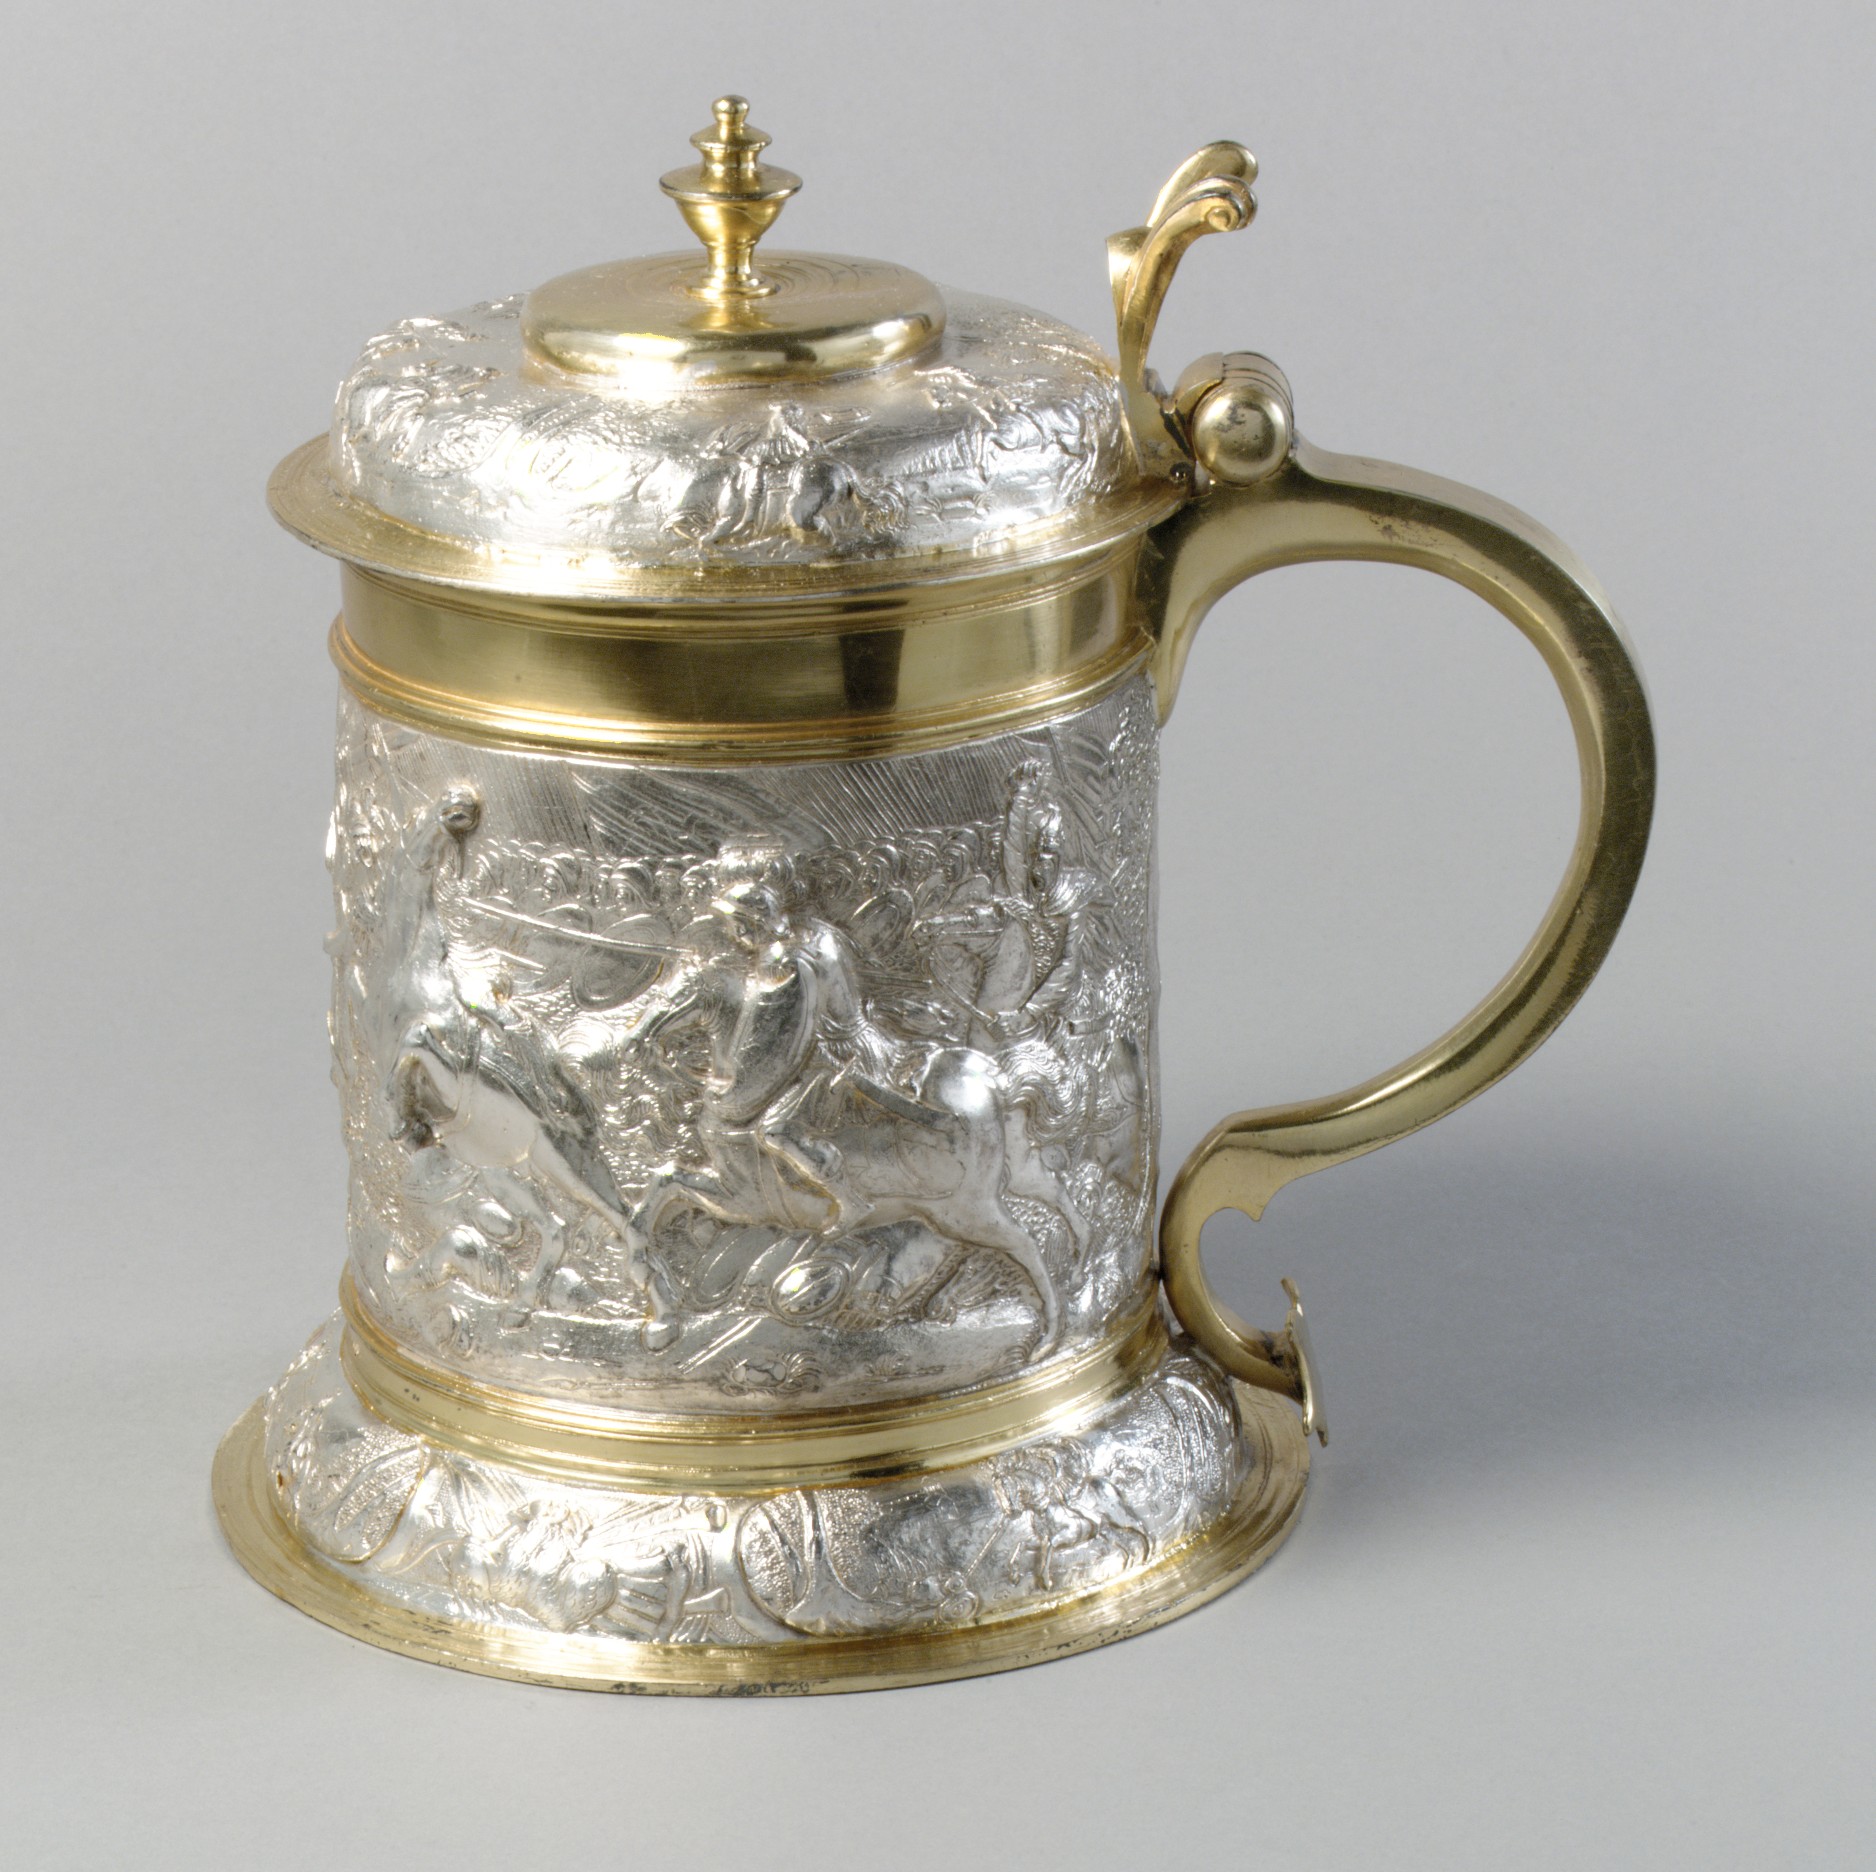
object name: tankard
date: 1801-1900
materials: metal, silver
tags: men,horses